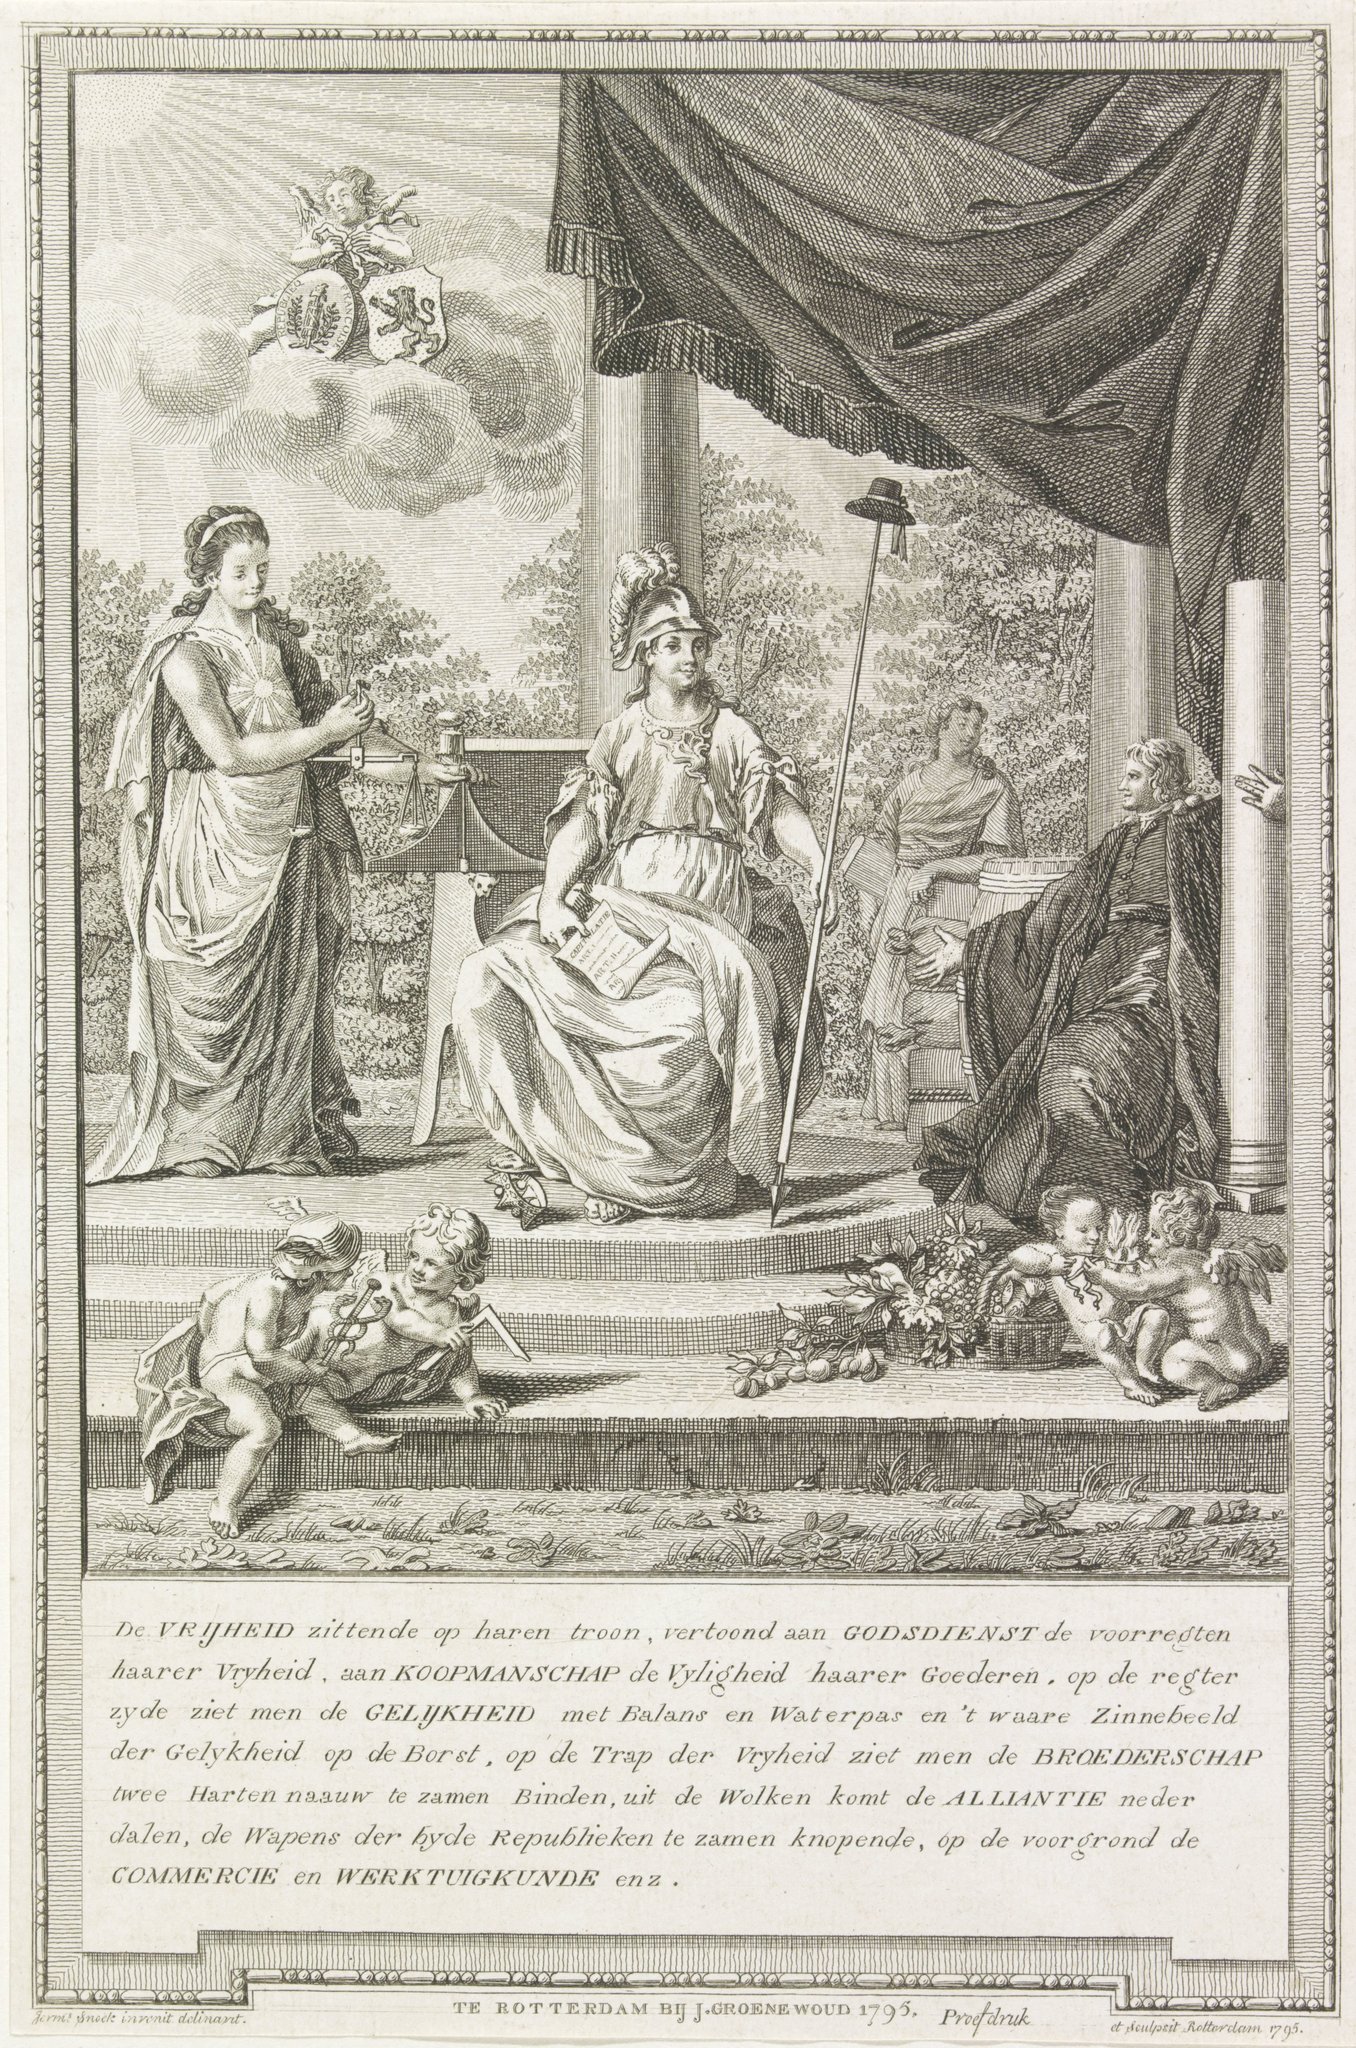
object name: print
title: Allegorie op de Alliantie met Frankrijk, 1795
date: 1795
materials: paper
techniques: engraving, etching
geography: rotterdam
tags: equality, equity, fairness, righteousness; 'equalità', 'equità', 'giuditio giusto', 'ordine dritto e giusto', 'ugualità' (ripa) (+ abstract concept represented by female figure), allegorical representations ~ religion; 'religione', 'religione de ss. mauritio e lazaro', 'religione vera christiana' (ripa), freedom, liberty; 'libertà' (ripa) (+ abstract concept represented by female figure), alliance with france (1795)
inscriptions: collector's mark: Lugt 2228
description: Allegorie op de Alliantie gesloten tussen de Bataafse Republiek en Frankrijk, 1795. Centraal de Vrijheid zittend op een troon, achter haar de Koopmanschap, links de Gelijkheid en rechts de Godsdienst (een predikant). Op de trappen links twee kinderen als de Commercie en Werktuigkunde, rechts twee kinderen als de Broederschap. In de wolken de Alliantie met de Franse en Nederlandse wapens. In het zevenregelige onderschrift de uitleg van de voorstelling.